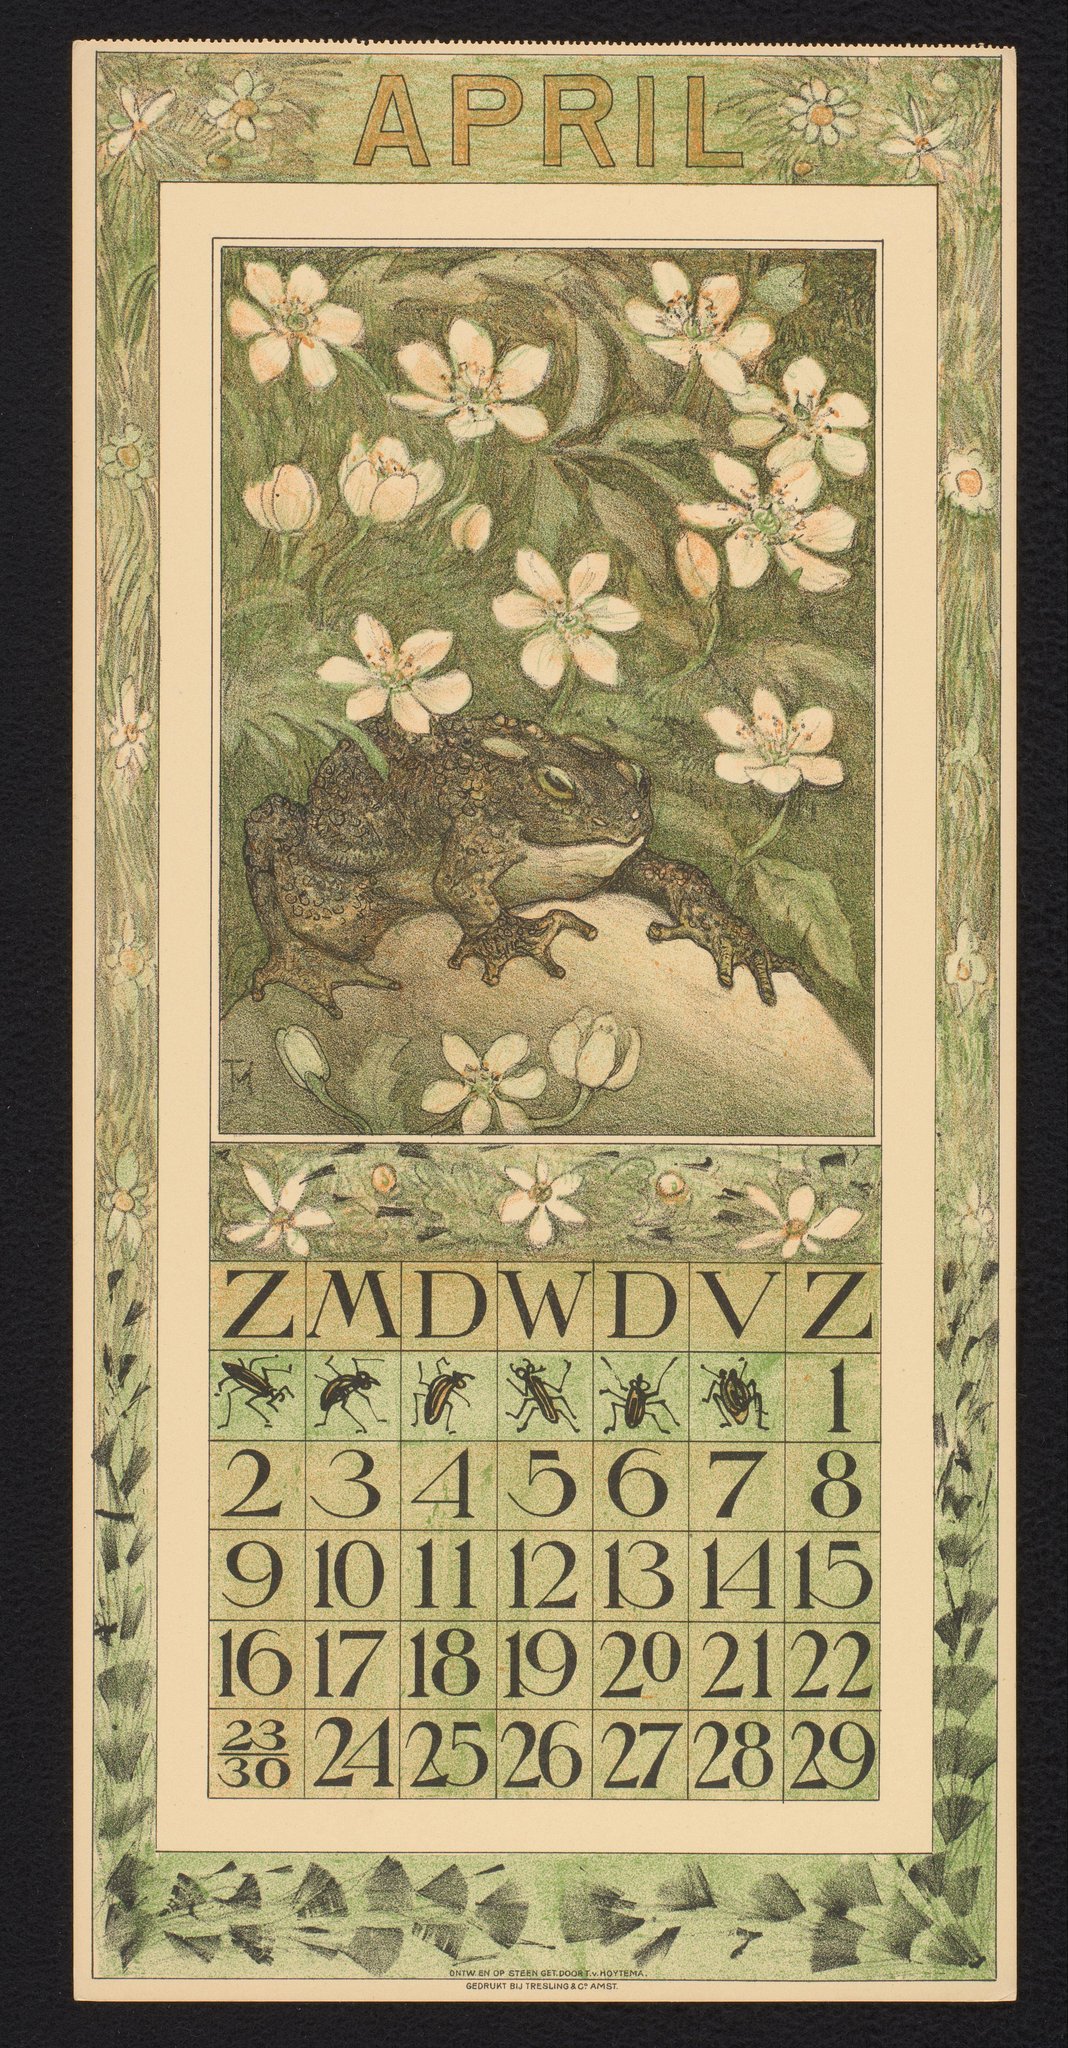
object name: calendar leaf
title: Kalenderblad voor april 1911 met een pad onder bloesem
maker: theo van hoytema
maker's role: draughtsman, painter, print maker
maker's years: 1863-1917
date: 1910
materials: paper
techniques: lithograph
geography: amsterdam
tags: tailless amphibians: toad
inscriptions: collector's mark: Lugt 2228